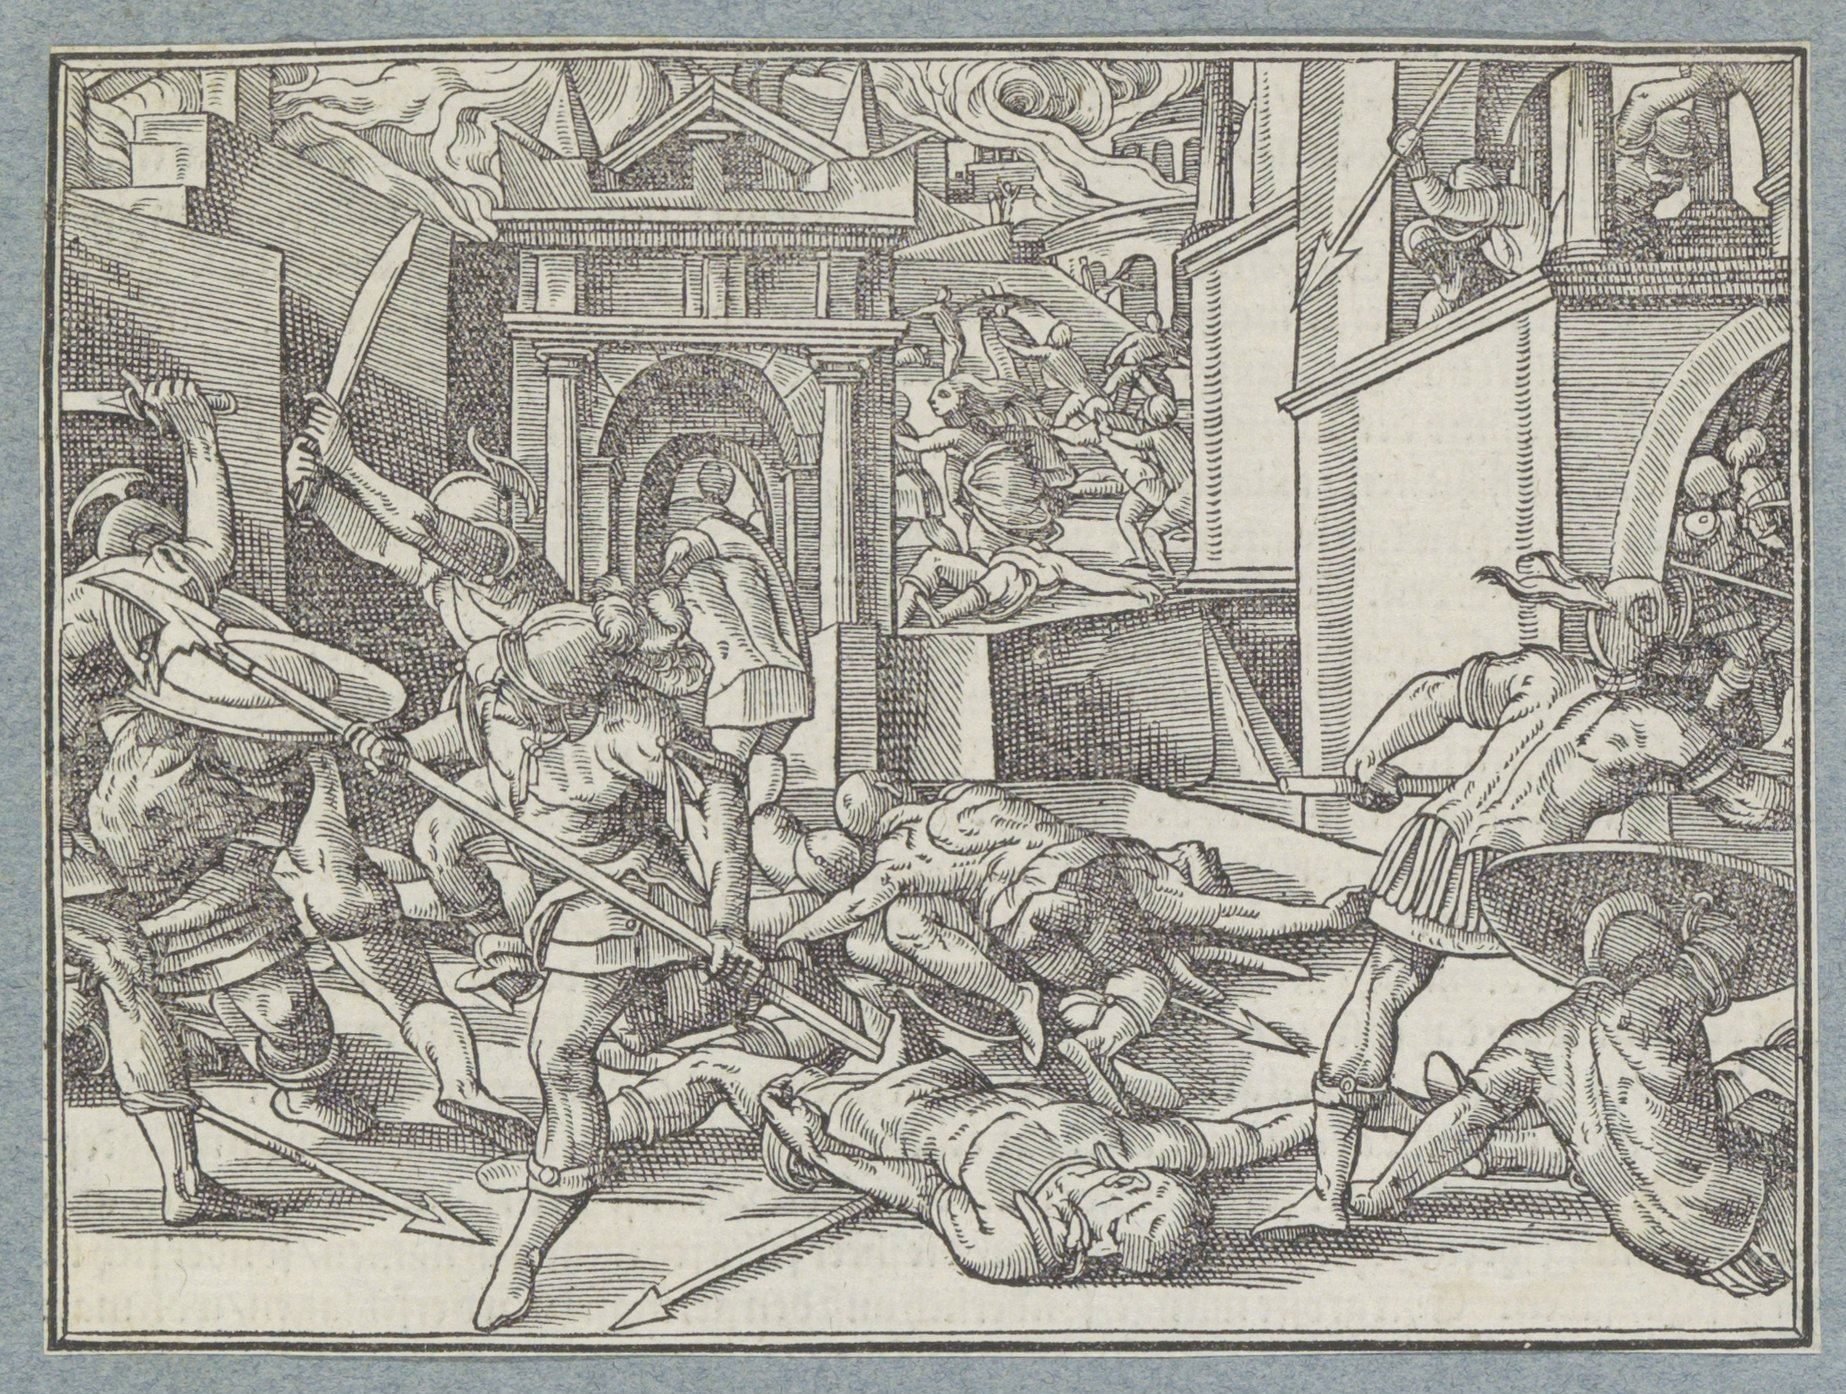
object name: book illustration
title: Vechtende soldaten in een stad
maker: christoffel van sichem (i)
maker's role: print maker, publisher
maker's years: 1546-1624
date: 1574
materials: paper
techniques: letterpress printing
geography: amsterdam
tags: battle, attack ~ siege, emperor titus destroying the temple of jerusalem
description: Krijgslieden met zwaarden en speren bevechten elkaar binnen de muren van een stad. Op de achtergrond vluchten de inwoners en gebouwen staan in brand. De voorstelling is onder meer gebruikt als afbeelding van de val van de stad Jeruzalem in 70 n.C. en de vernietiging van de grote tempel door Titus. De prent maakt deel uit van een album.